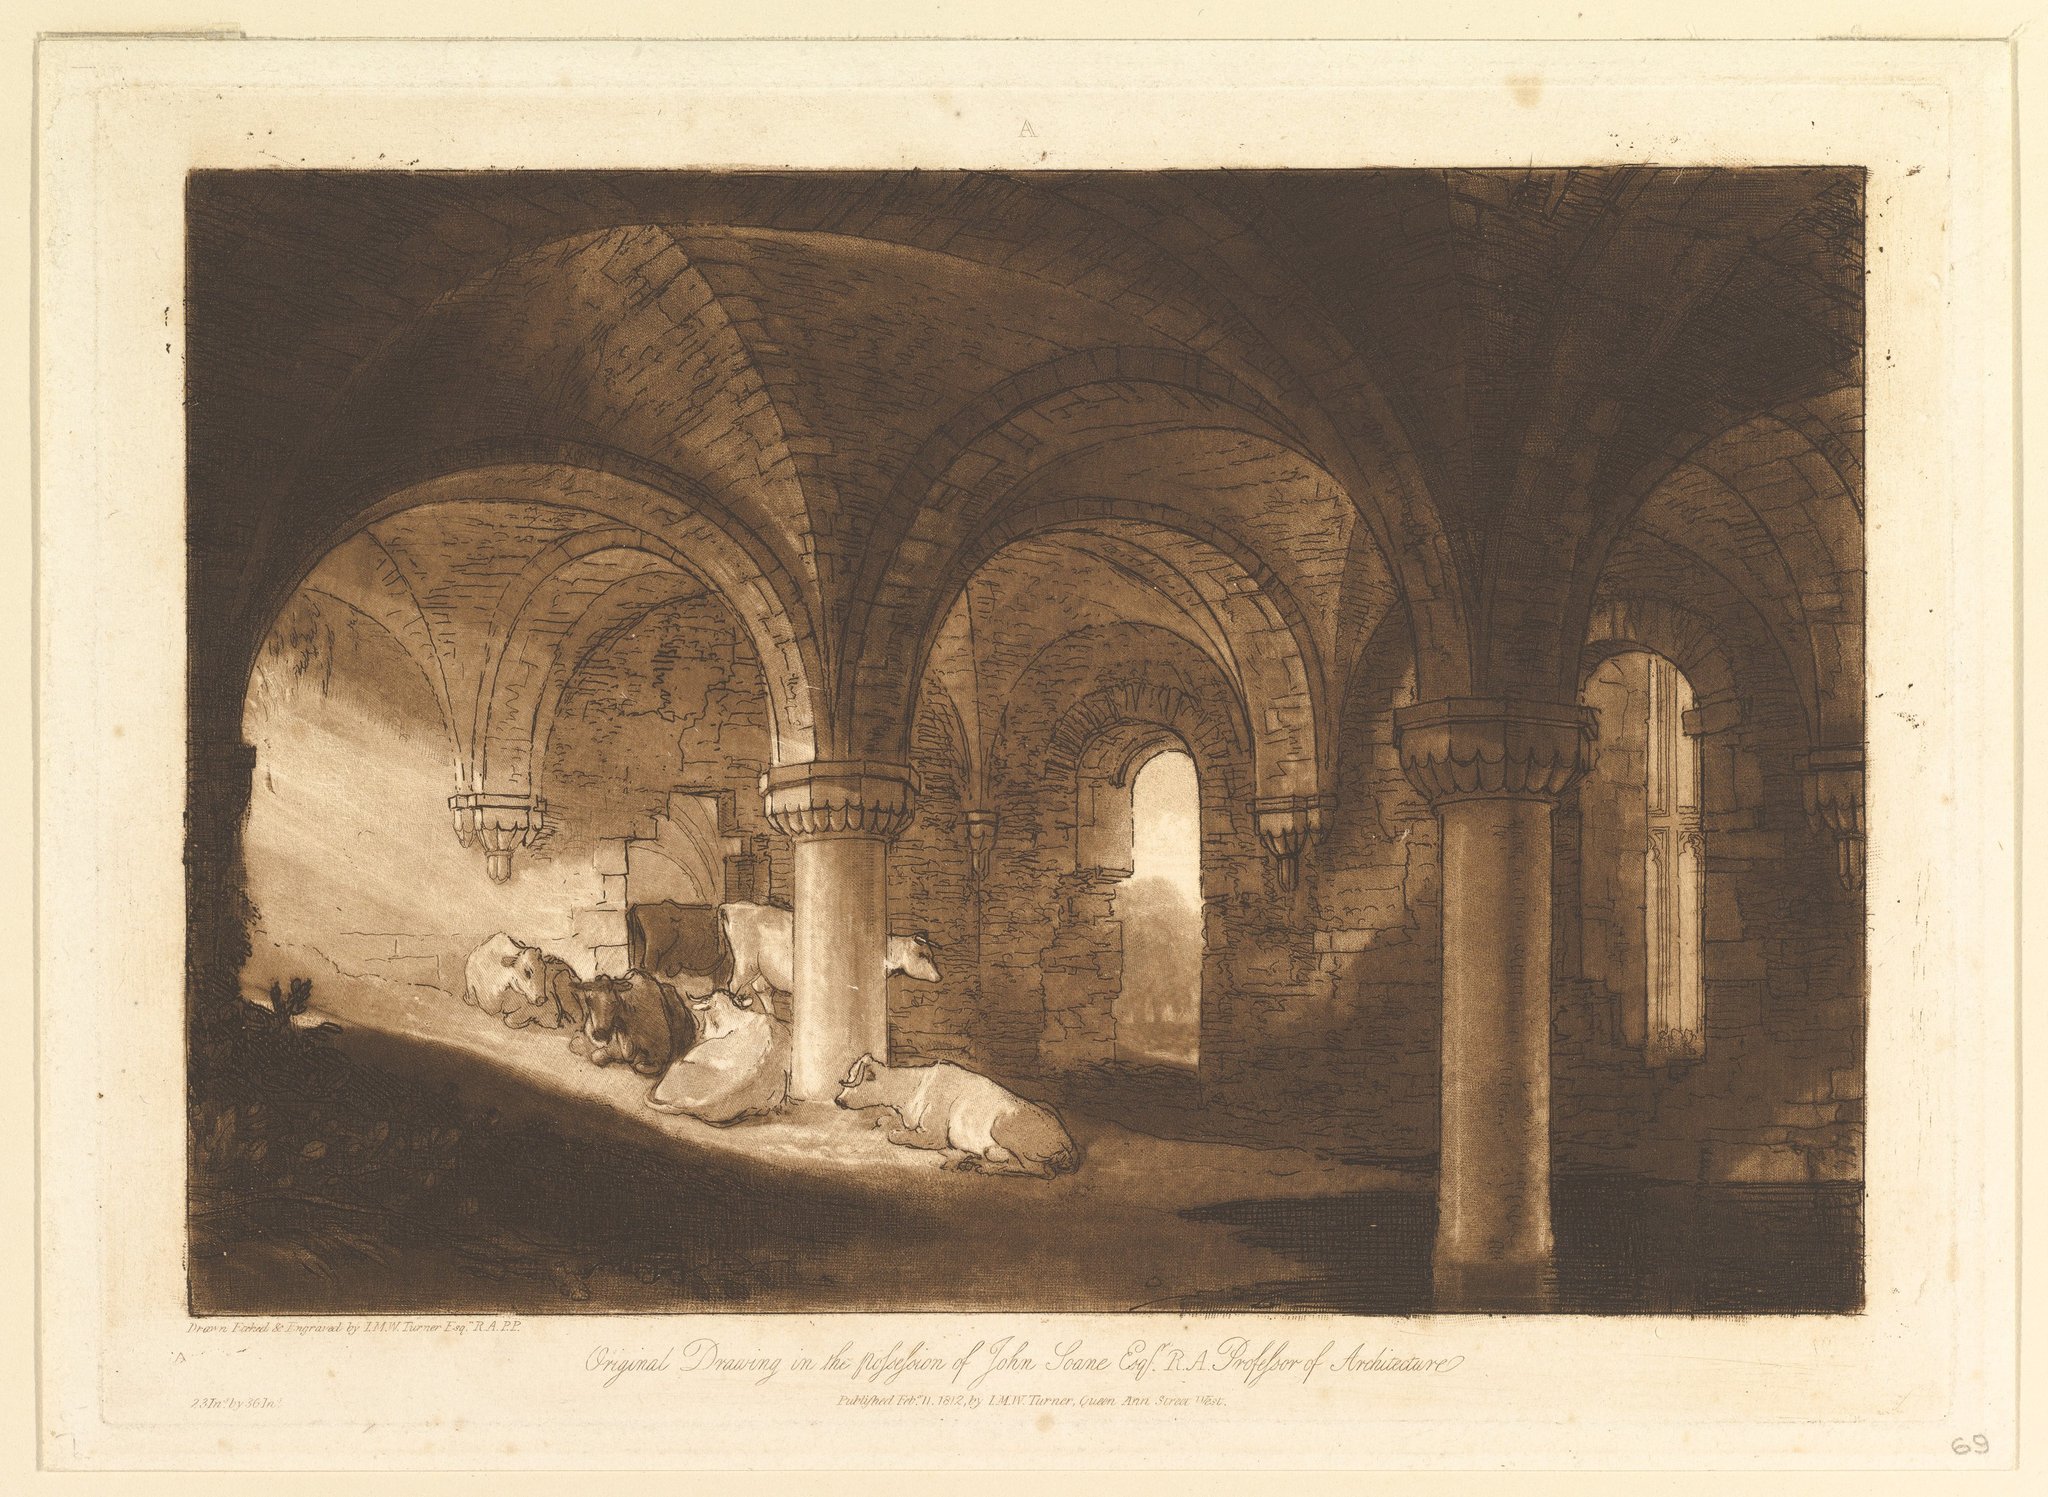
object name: print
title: Crypt of Kirkstall Abbey (Liber Studiorum, part VIII, plate 39)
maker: joseph mallord william turner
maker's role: artist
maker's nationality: british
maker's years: 1775-1851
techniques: aquatint, etching, mezzotint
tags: crypts,cows